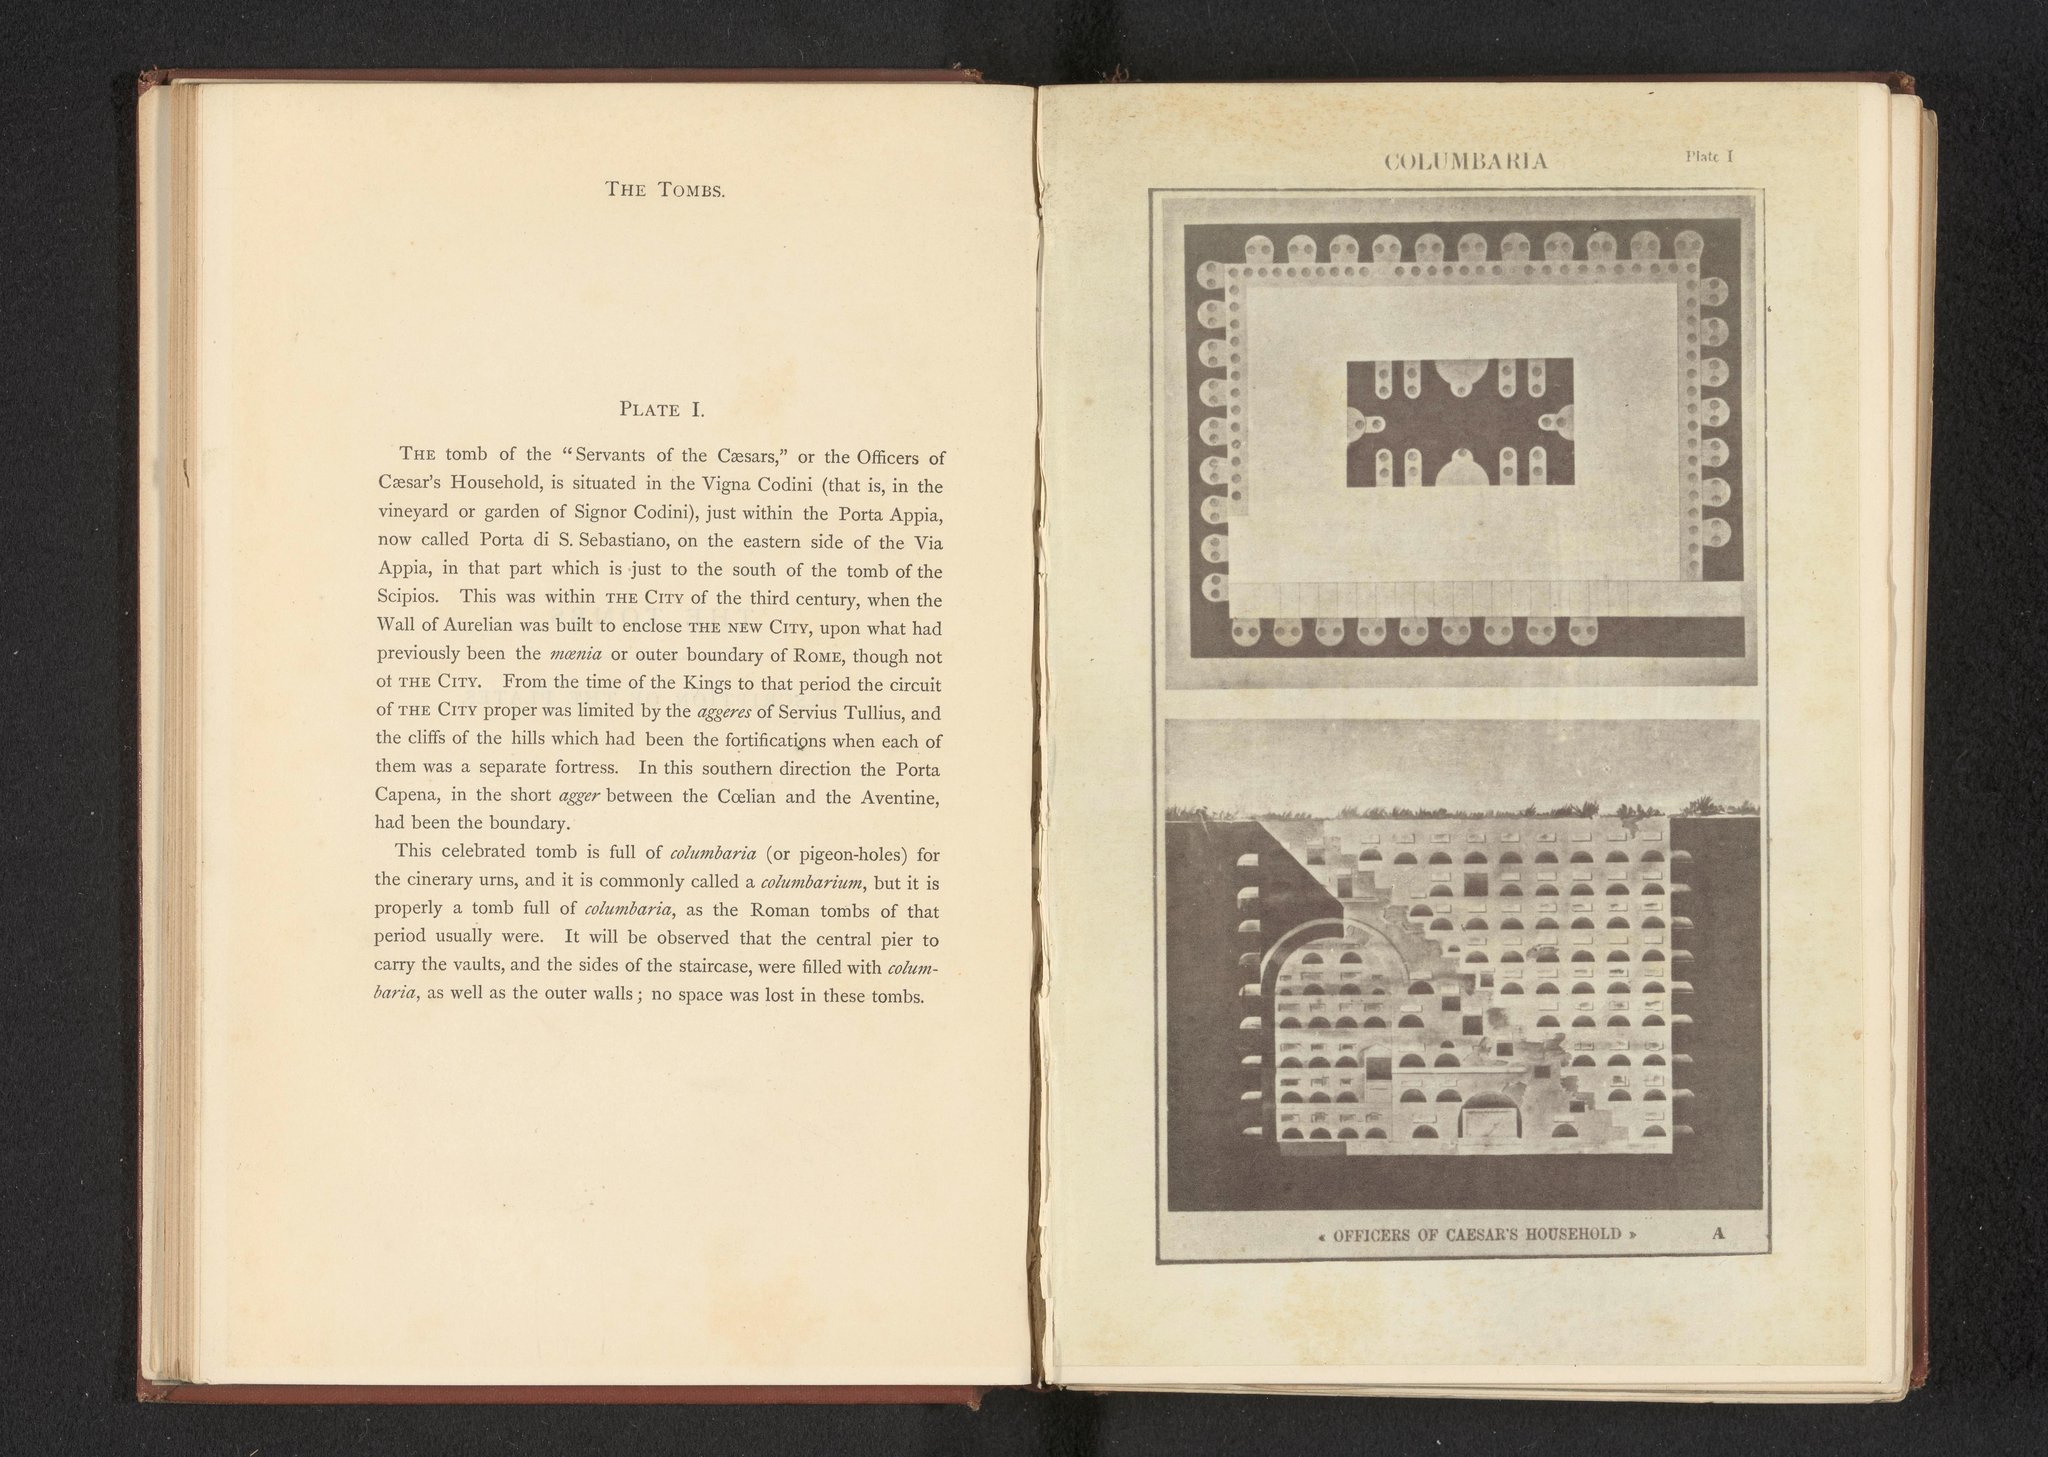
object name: reproduction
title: Columbaria Officers of Caesar's household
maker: Anonymous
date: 1867-1877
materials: paper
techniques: photograph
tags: niche-tomb, wall-tomb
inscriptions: number: ‘Plate I A’